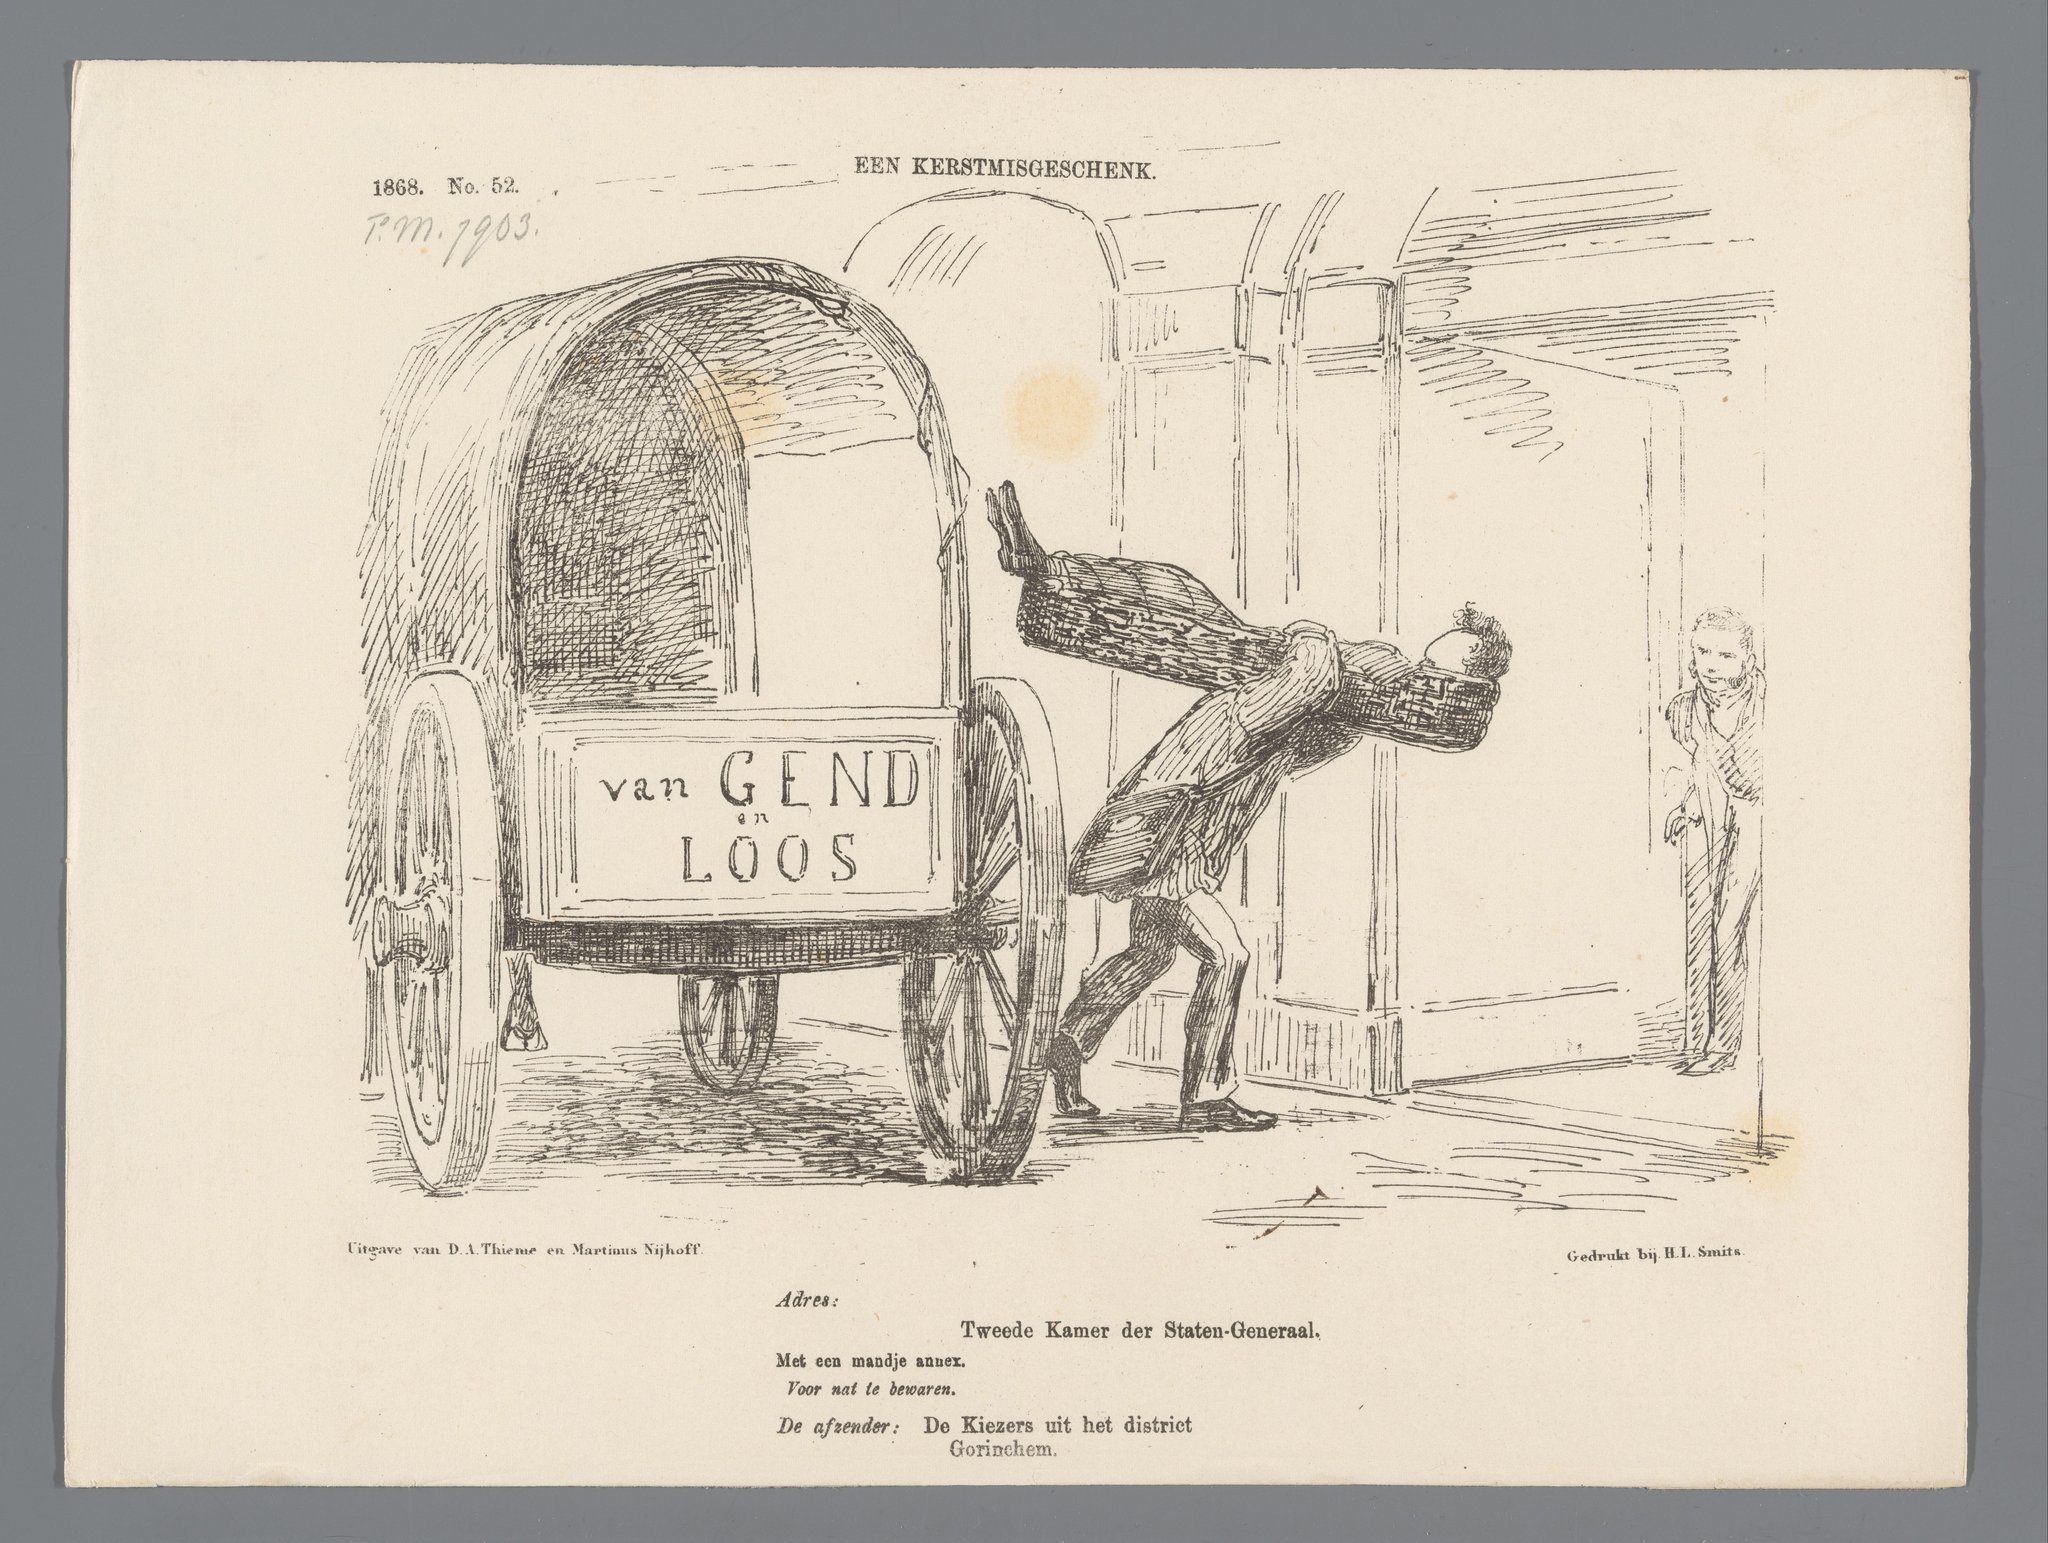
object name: print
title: Een Kerstmisgeschenk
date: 1867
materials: paper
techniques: lithograph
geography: the hague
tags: christmas (non-liturgical celebration)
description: Spotprent waarin Jan Heemskerk door Van Gend en Loos als kerstgeschenk bij de Tweede Kamer wordt bezorgd. Plaat verschenen bij het weekblad De Nederlandsche Spectator, nr. 52, 26 december 1868.